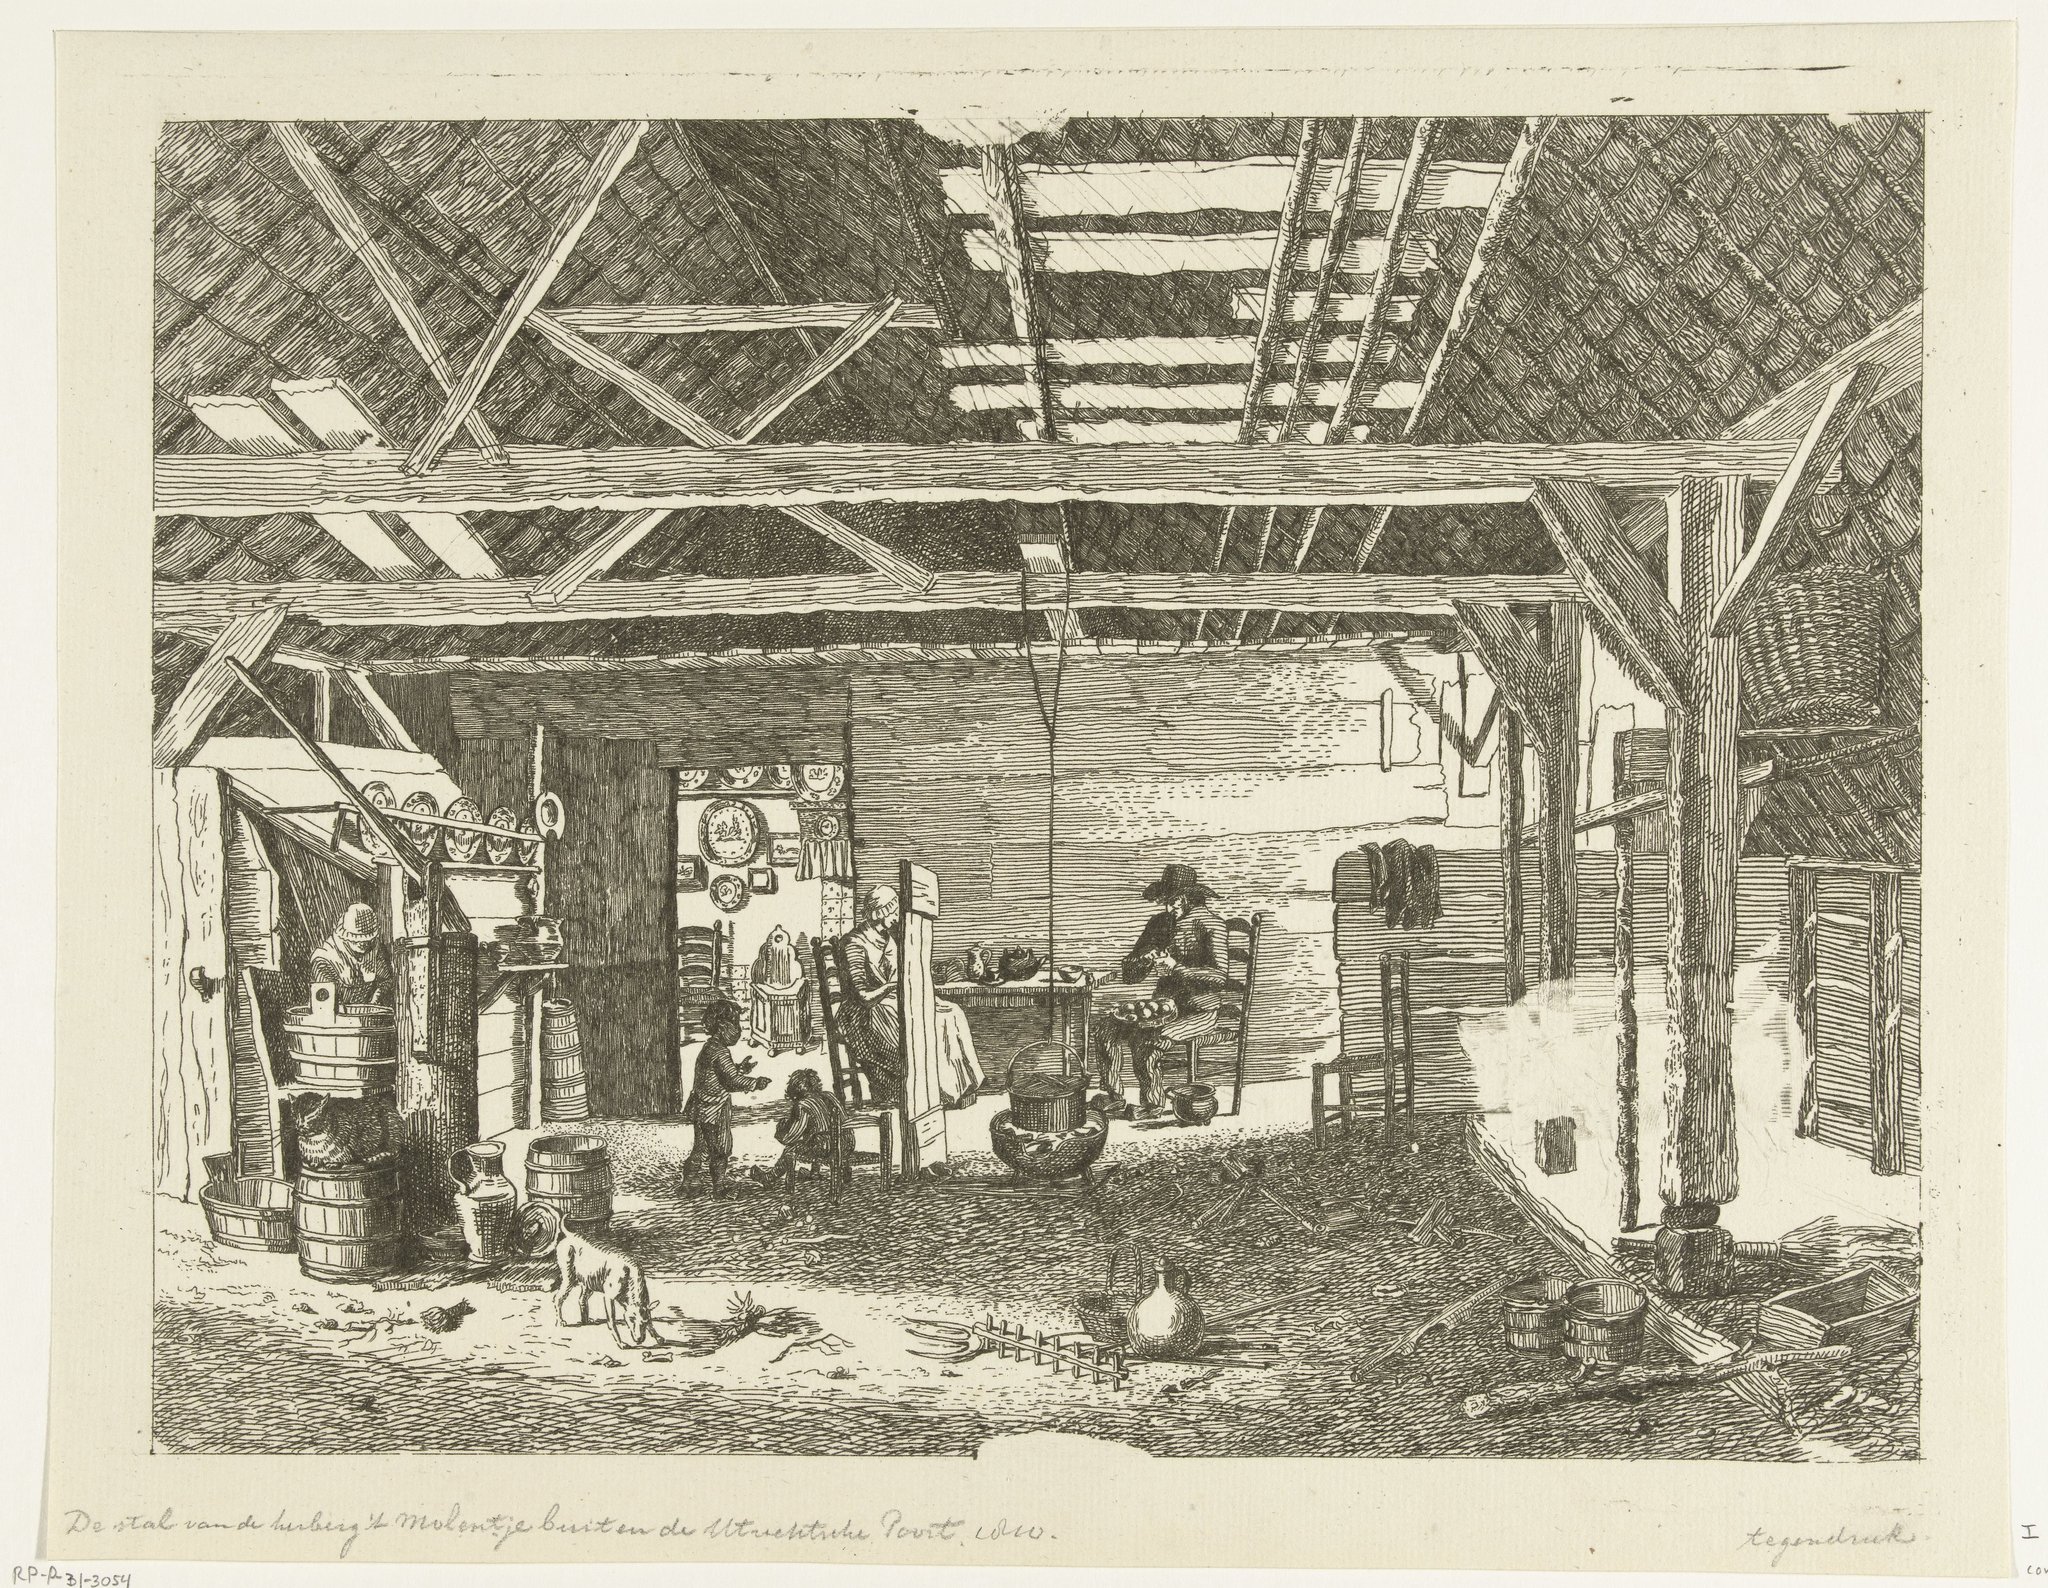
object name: print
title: De stal van de herberg 't Molentje buiten de Utrechtse Poort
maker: anthonie van den bos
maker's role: draughtsman, print maker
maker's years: 1763-1838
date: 1810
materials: paper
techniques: printmaking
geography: netherlands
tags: barn, farmers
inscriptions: collector's mark: Lugt 2228